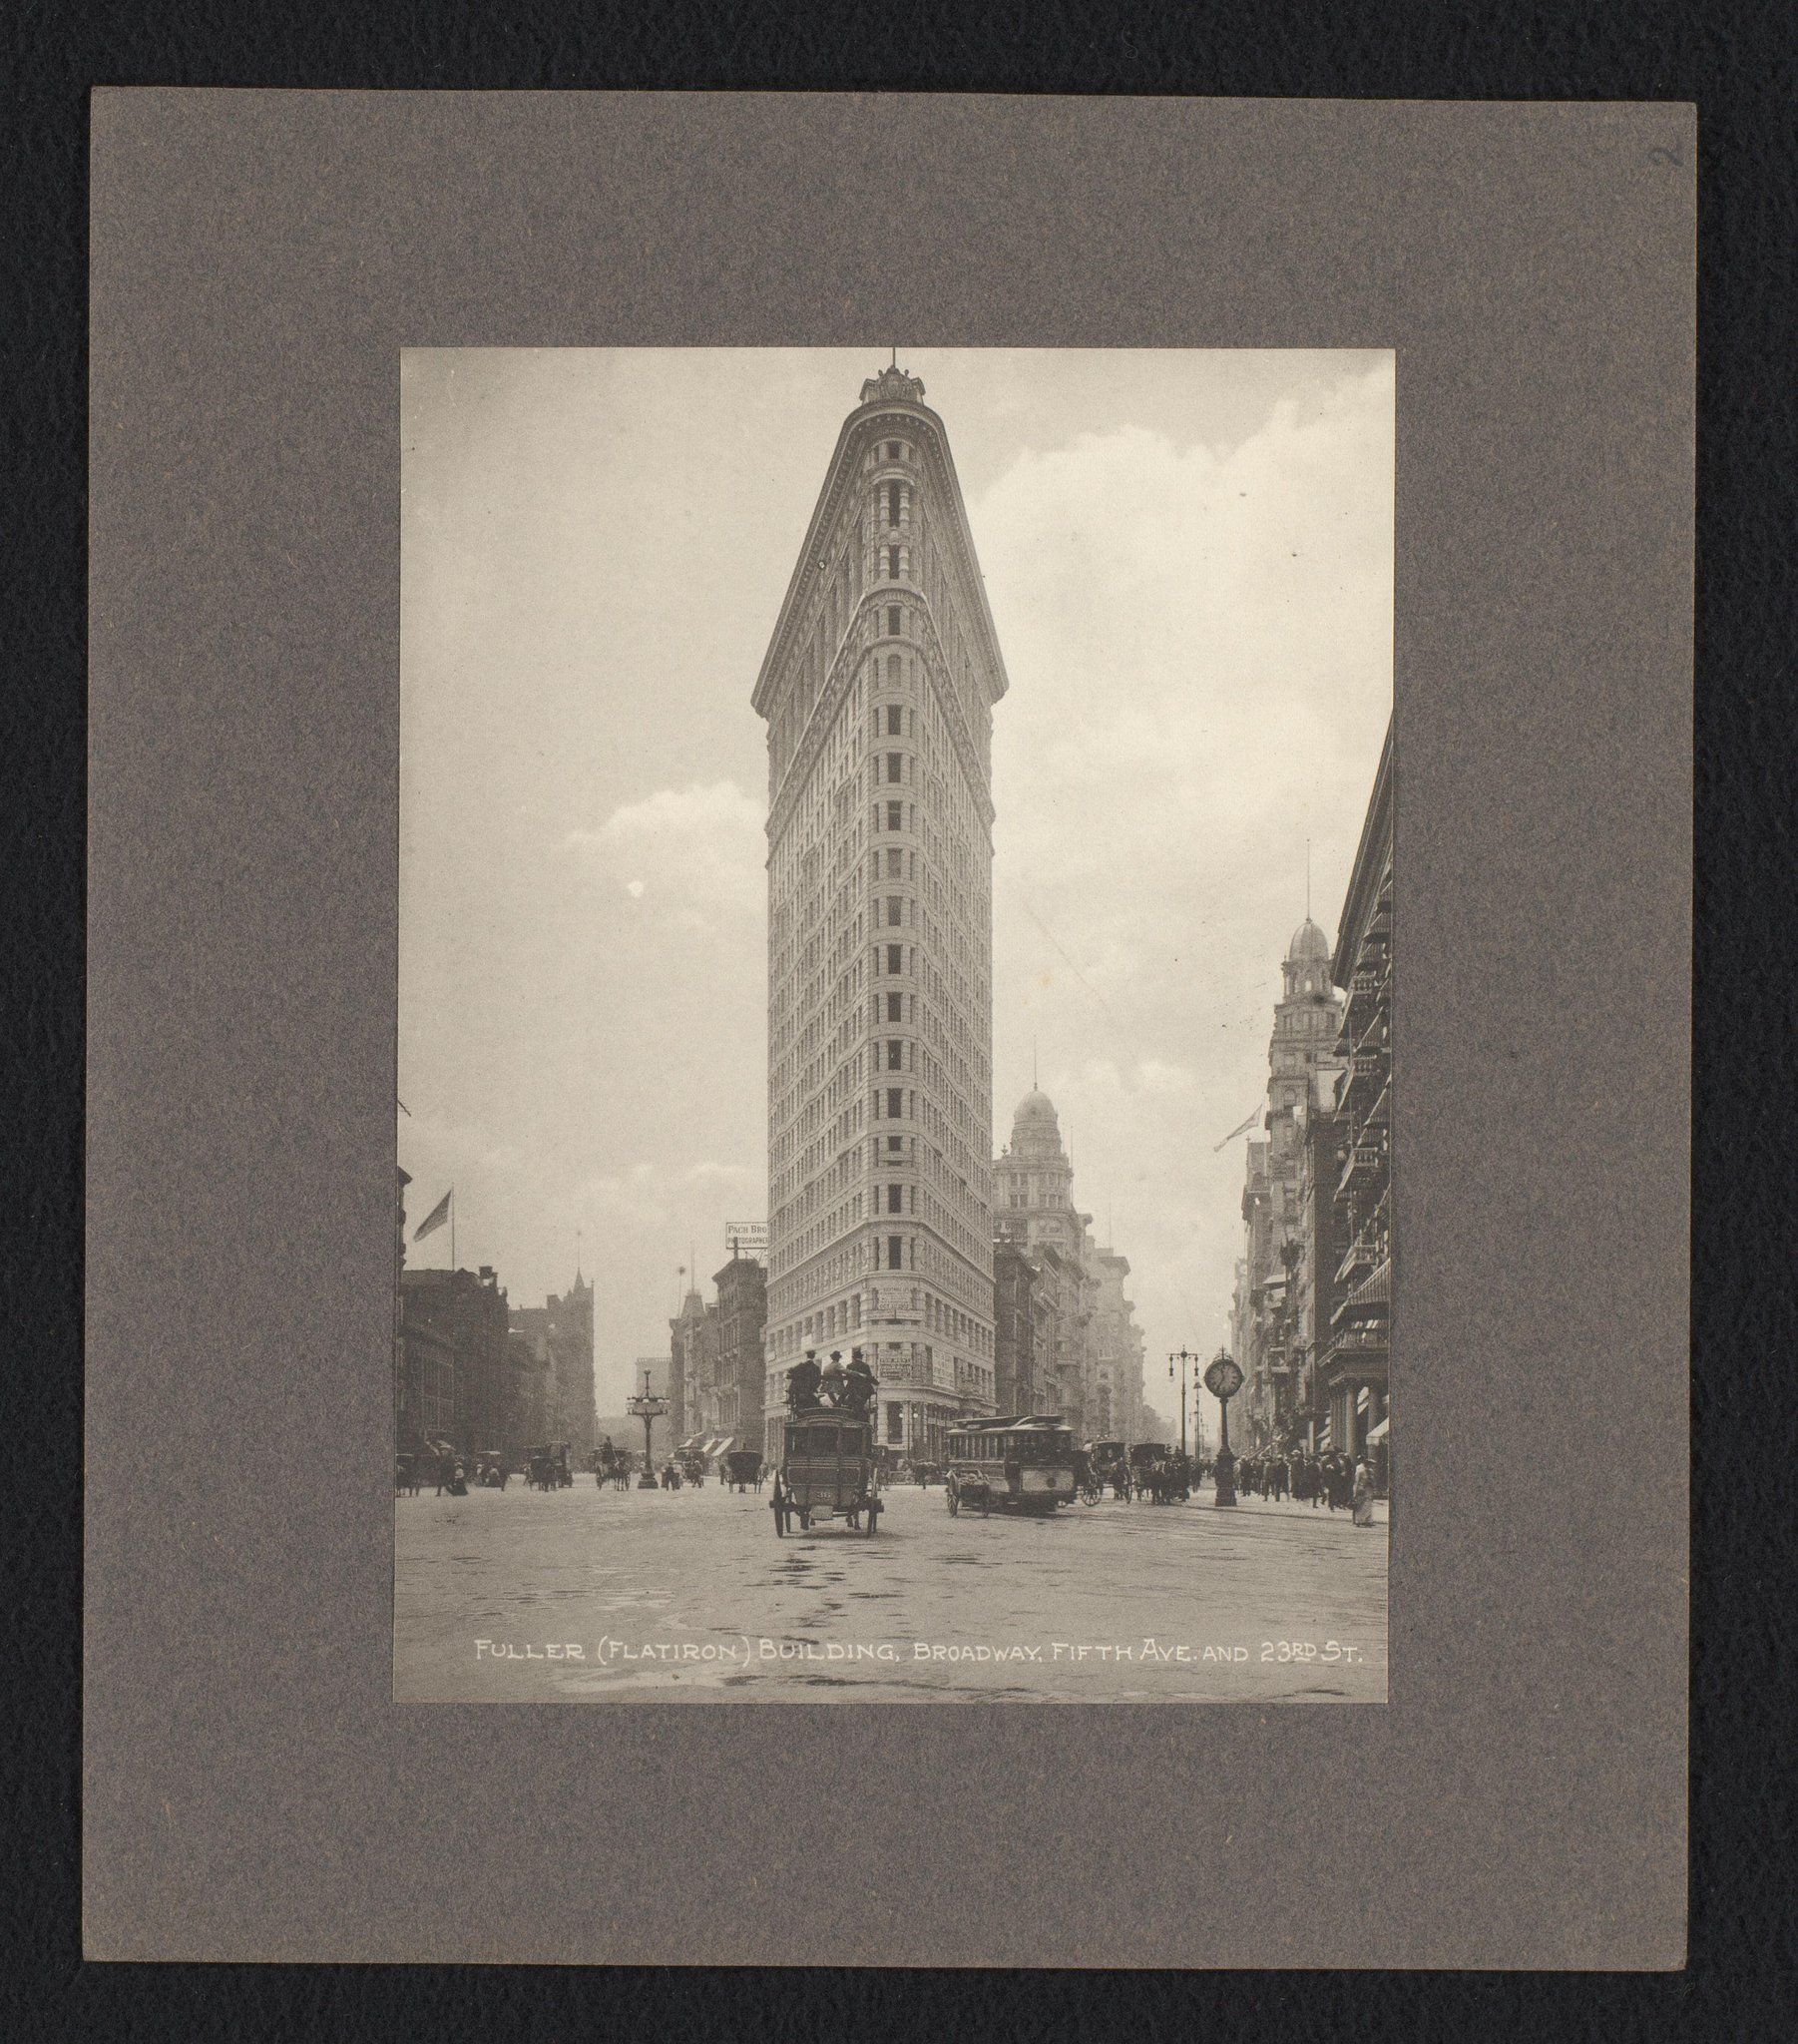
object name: album leaf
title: Fuller (flatiron) building, Broadway, Fifth Ave, and 23rd street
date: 1902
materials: paper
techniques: photograph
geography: new york city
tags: four-wheeled, animal-drawn vehicle, e.g.: cab, carriage, coach, exterior ~ representation of a building, street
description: Deze prent maakt deel uit van een album.